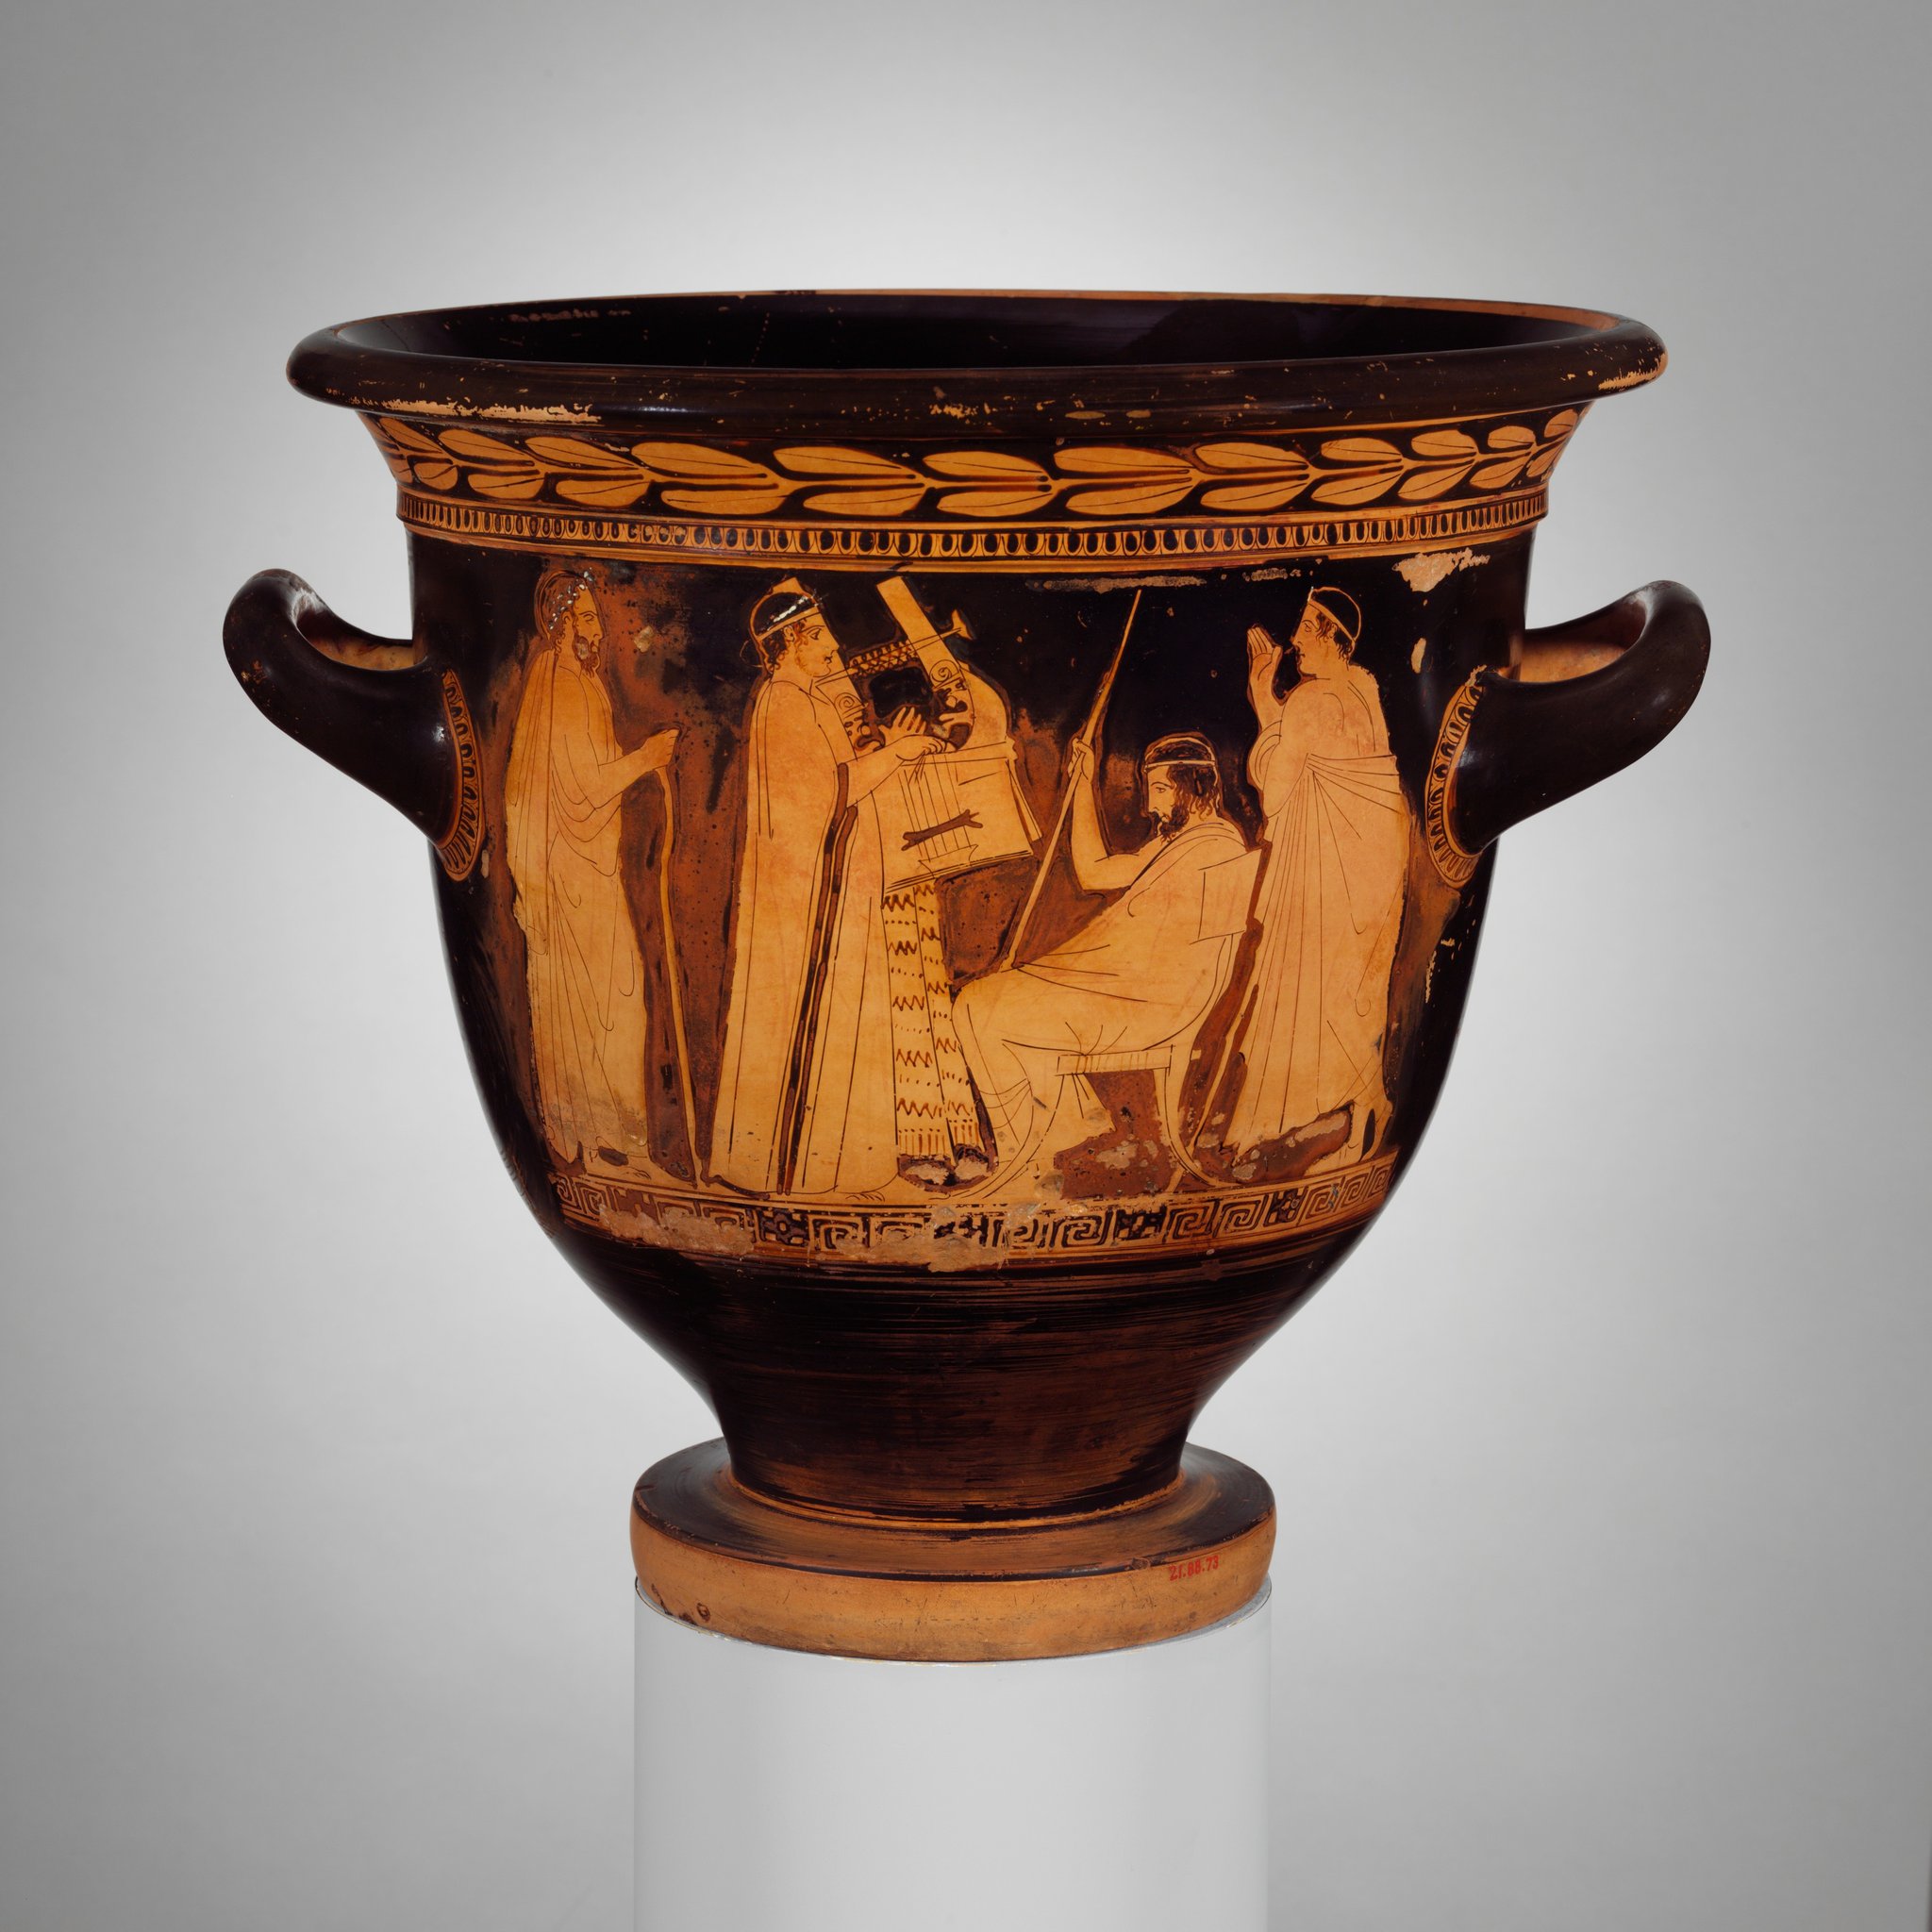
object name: bell krater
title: Terracotta bell-krater (bowl for mixing wine and water)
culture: greek, attic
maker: polygnotos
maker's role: artist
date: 450-440 BCE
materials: terracotta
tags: musical instruments,men